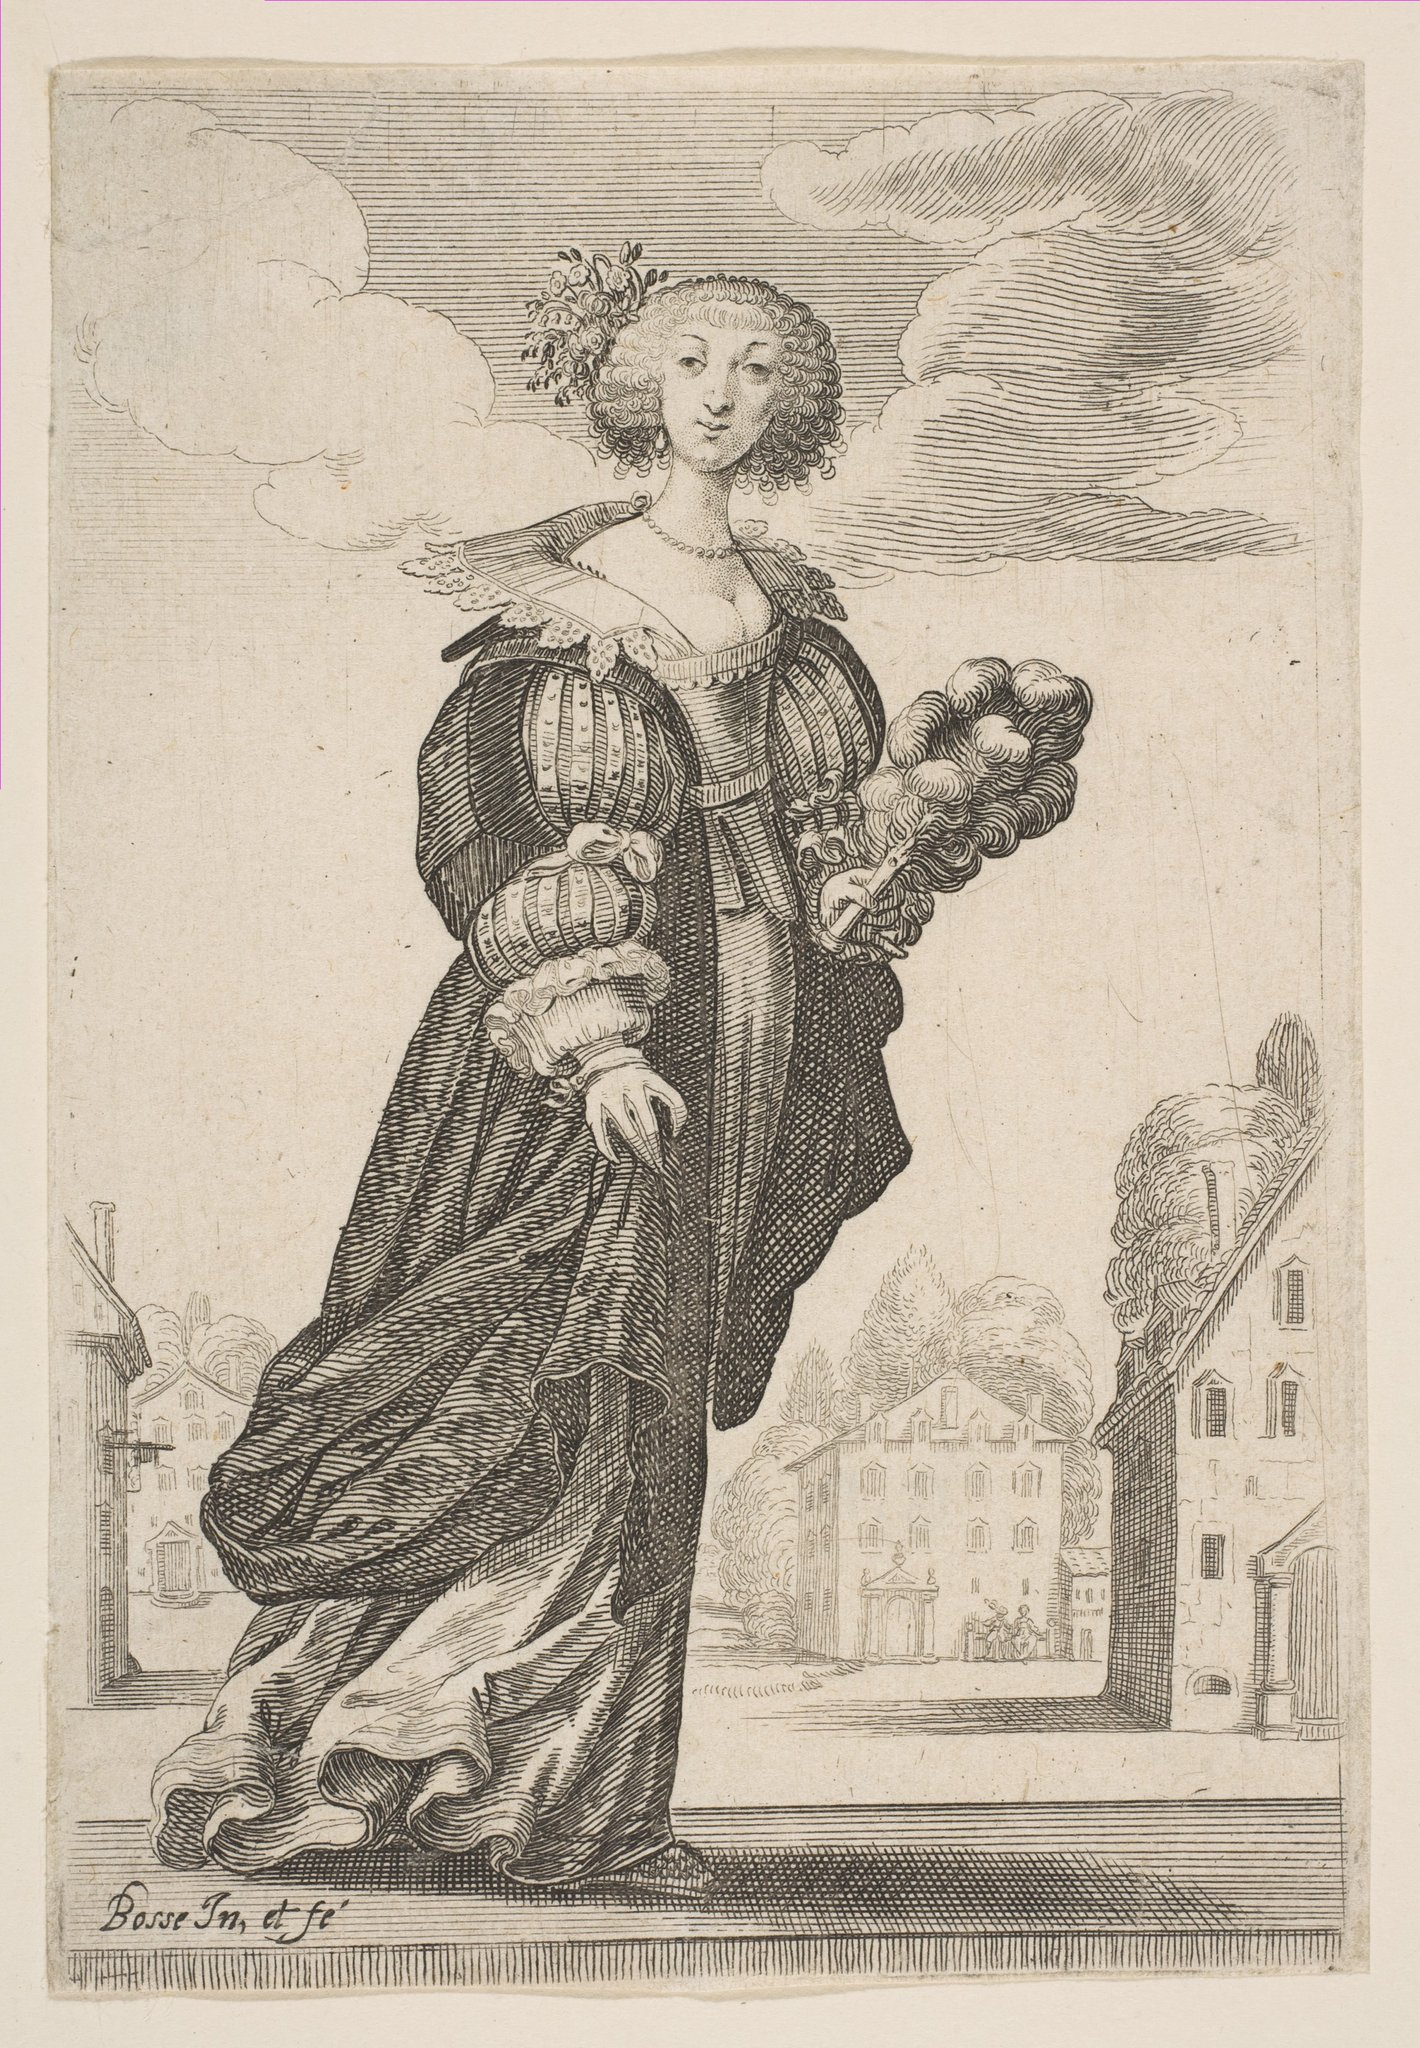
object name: print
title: Woman Holding a Fan, from "The Garden of the French Nobles In Which One Can Pick Up Their Way of Dressing"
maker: abraham bosse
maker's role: artist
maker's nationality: french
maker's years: 1602-1676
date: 1629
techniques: etching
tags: fans,women